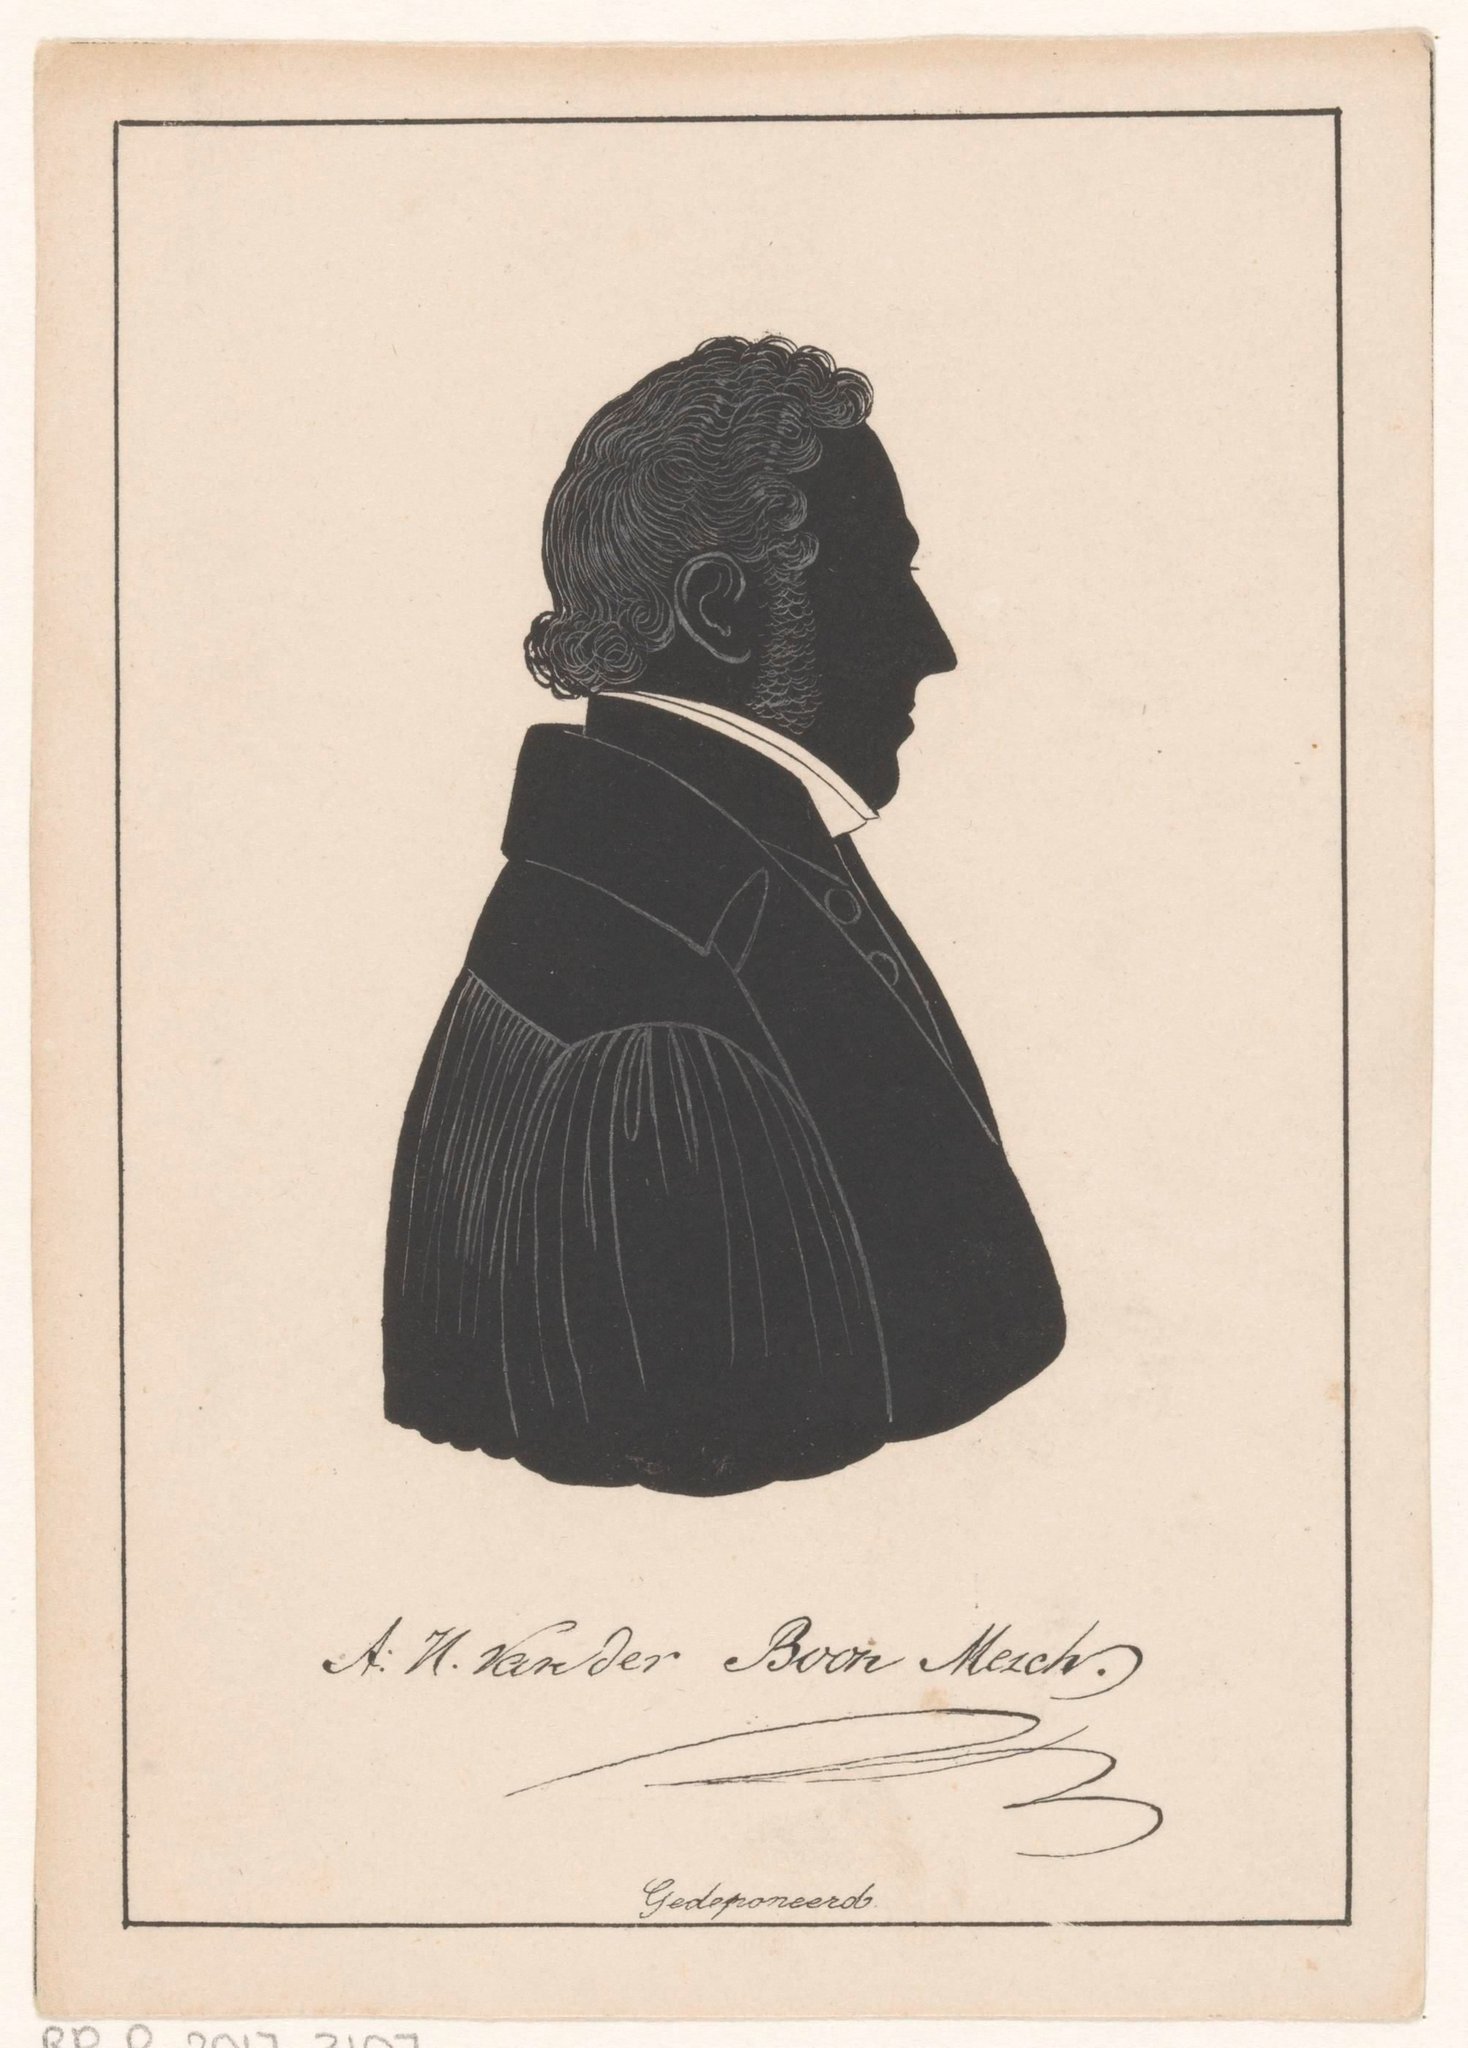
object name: print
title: Silhouetportret van Anthony Hendrik van der Boon Mesch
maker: pieter barbiers (iv)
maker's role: painter, print maker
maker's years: 1798-1848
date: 1809-1848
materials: paper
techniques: hand coloring, lithograph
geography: netherlands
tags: delft, leiden, historical persons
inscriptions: : ‘Gedeponeerd.’, collector's mark: Lugt 2228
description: Onder het portret de signatuur van de geportretteerde.